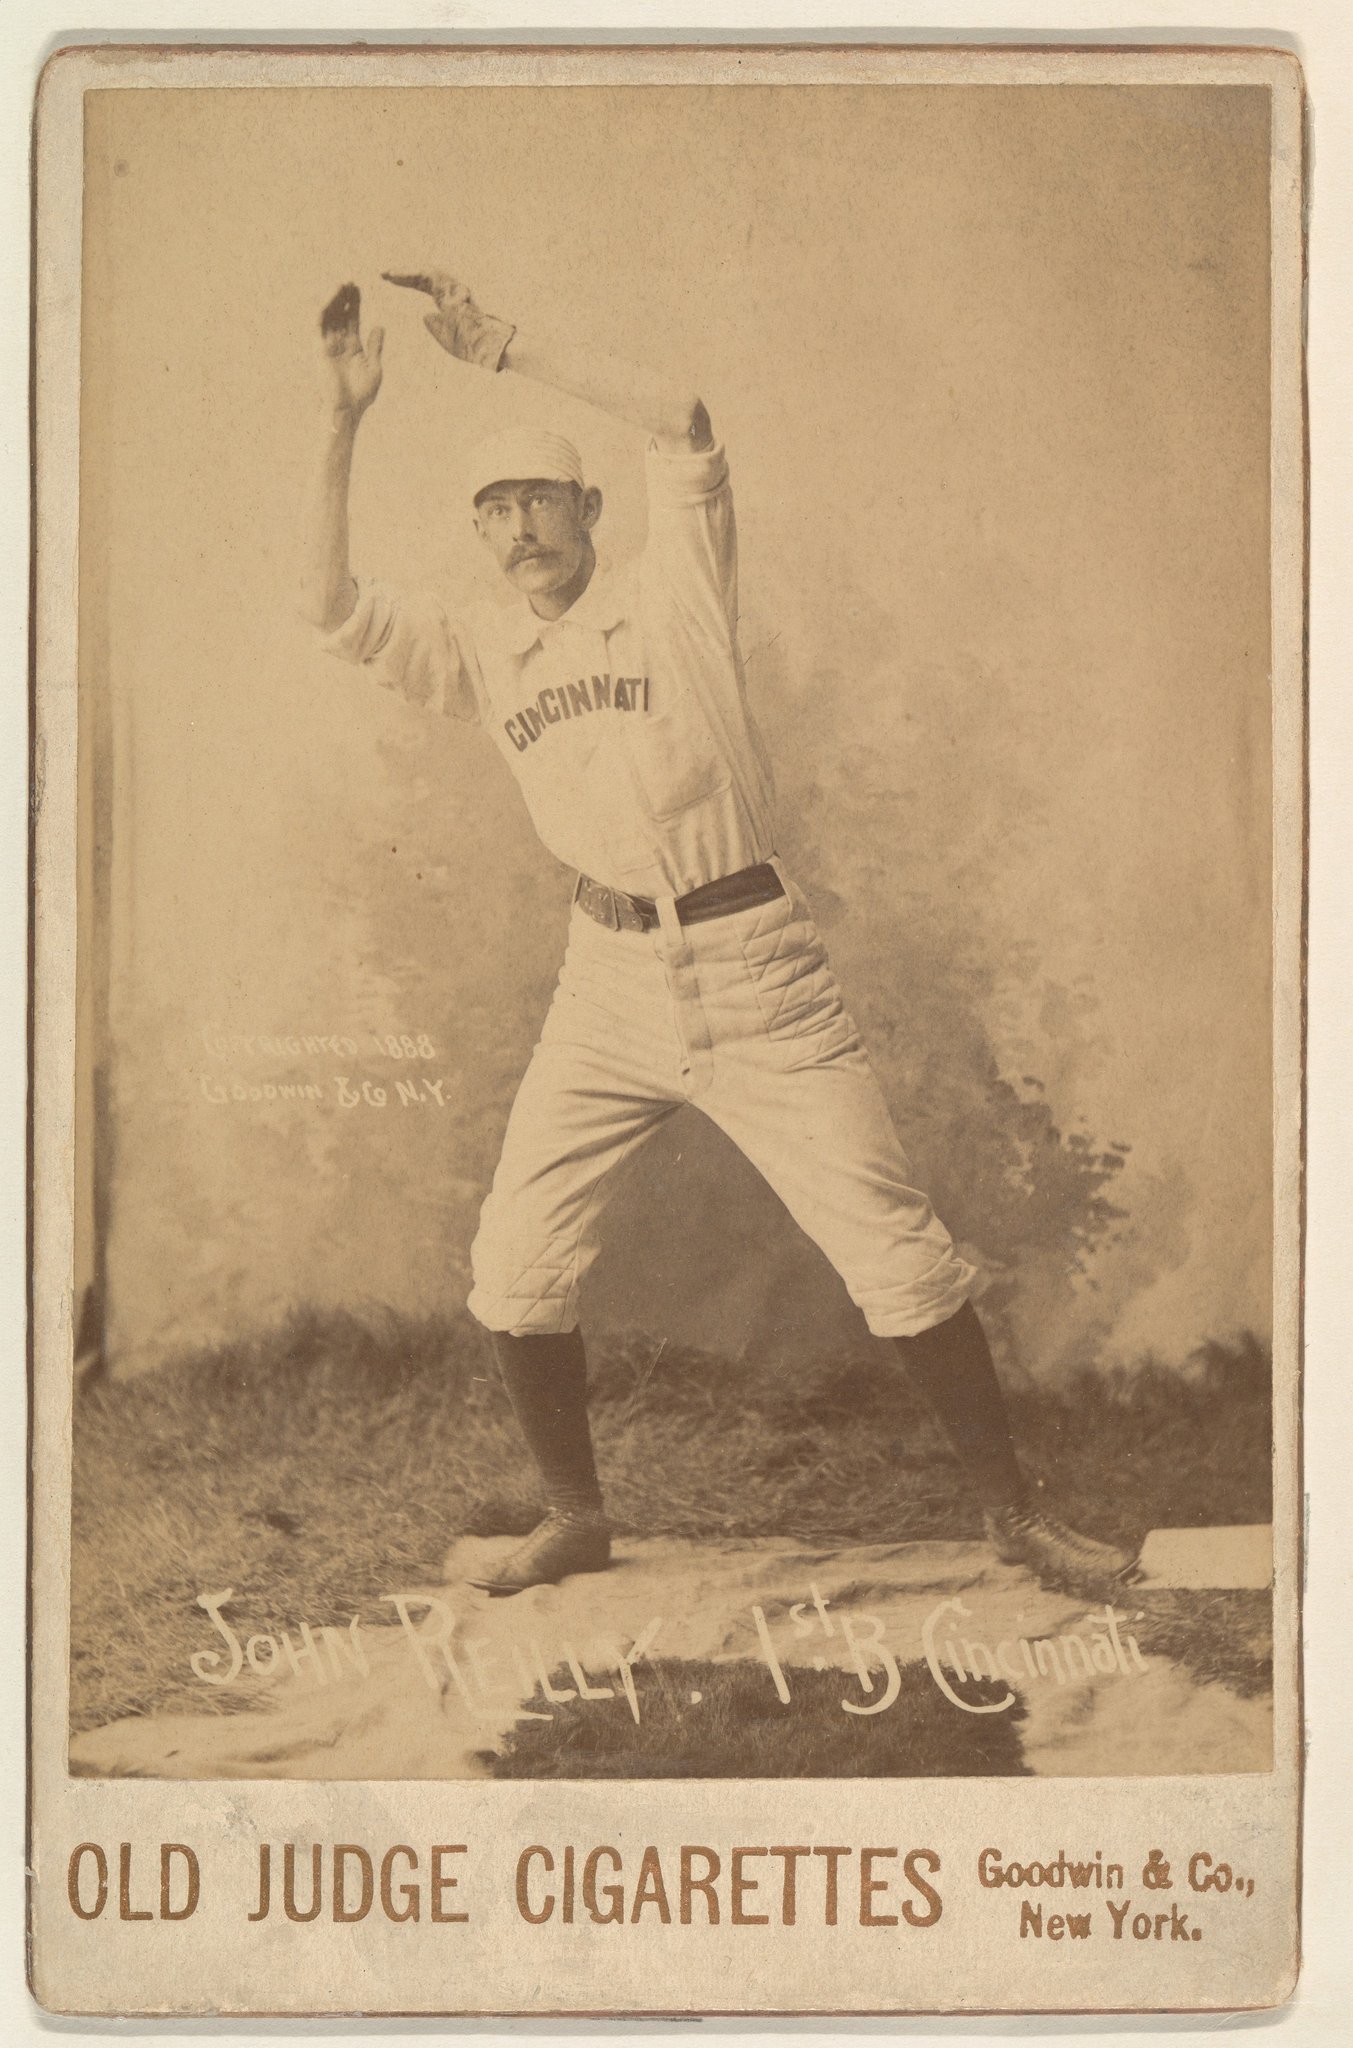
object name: baseball card, photograph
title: John Reilly, 1st Base, Cincinnati, from the series Old Judge Cigarettes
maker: goodwin & company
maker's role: publisher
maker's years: 1850-1950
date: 1887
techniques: albumen print, photography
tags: men,portraits,baseball,athletes